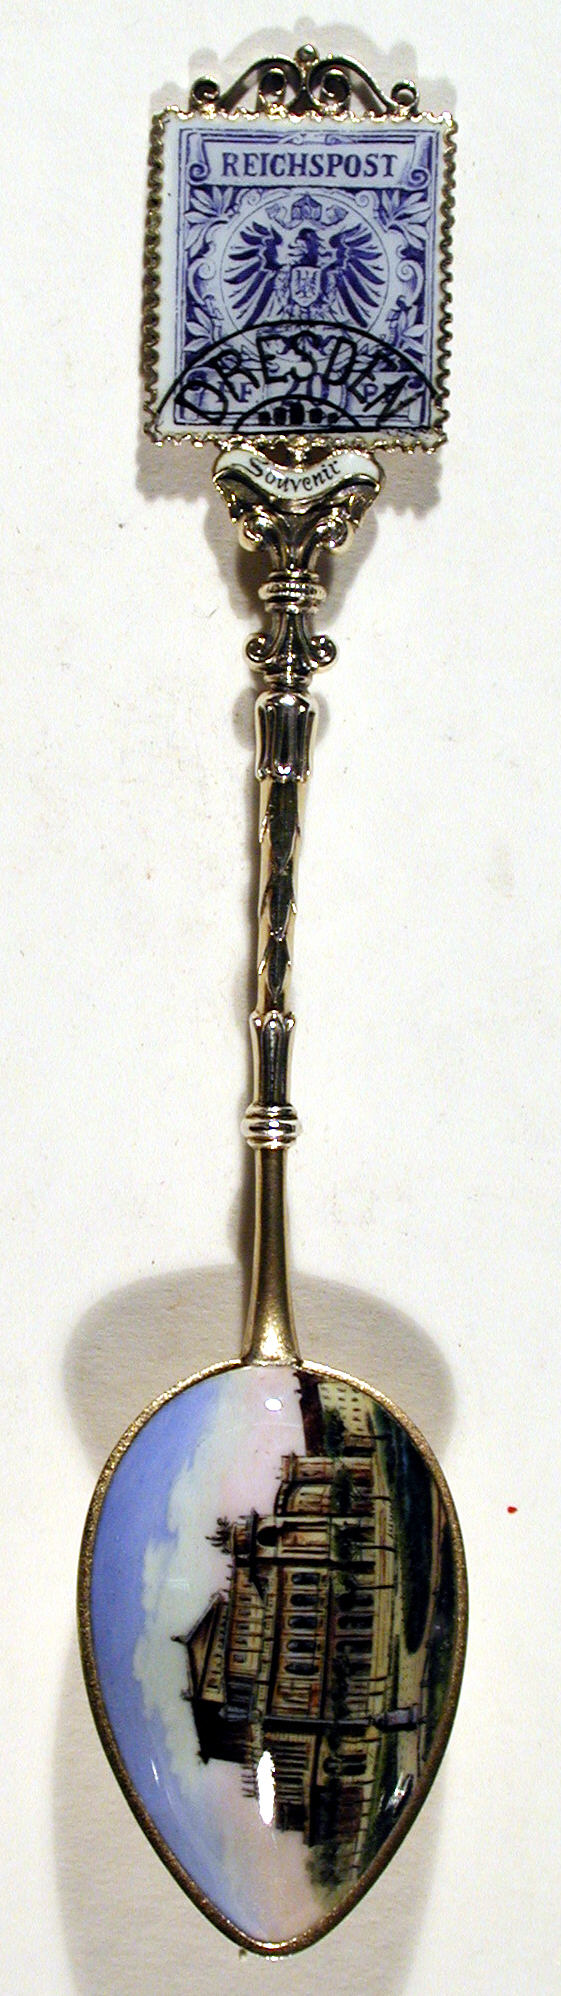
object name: souvenir spoon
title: Souvenir spoon with a Dresden building (possibly General Post Office) and finial in form of postage stamp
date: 1867-1900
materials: enamel, silver gilt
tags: buildings,coat of arms